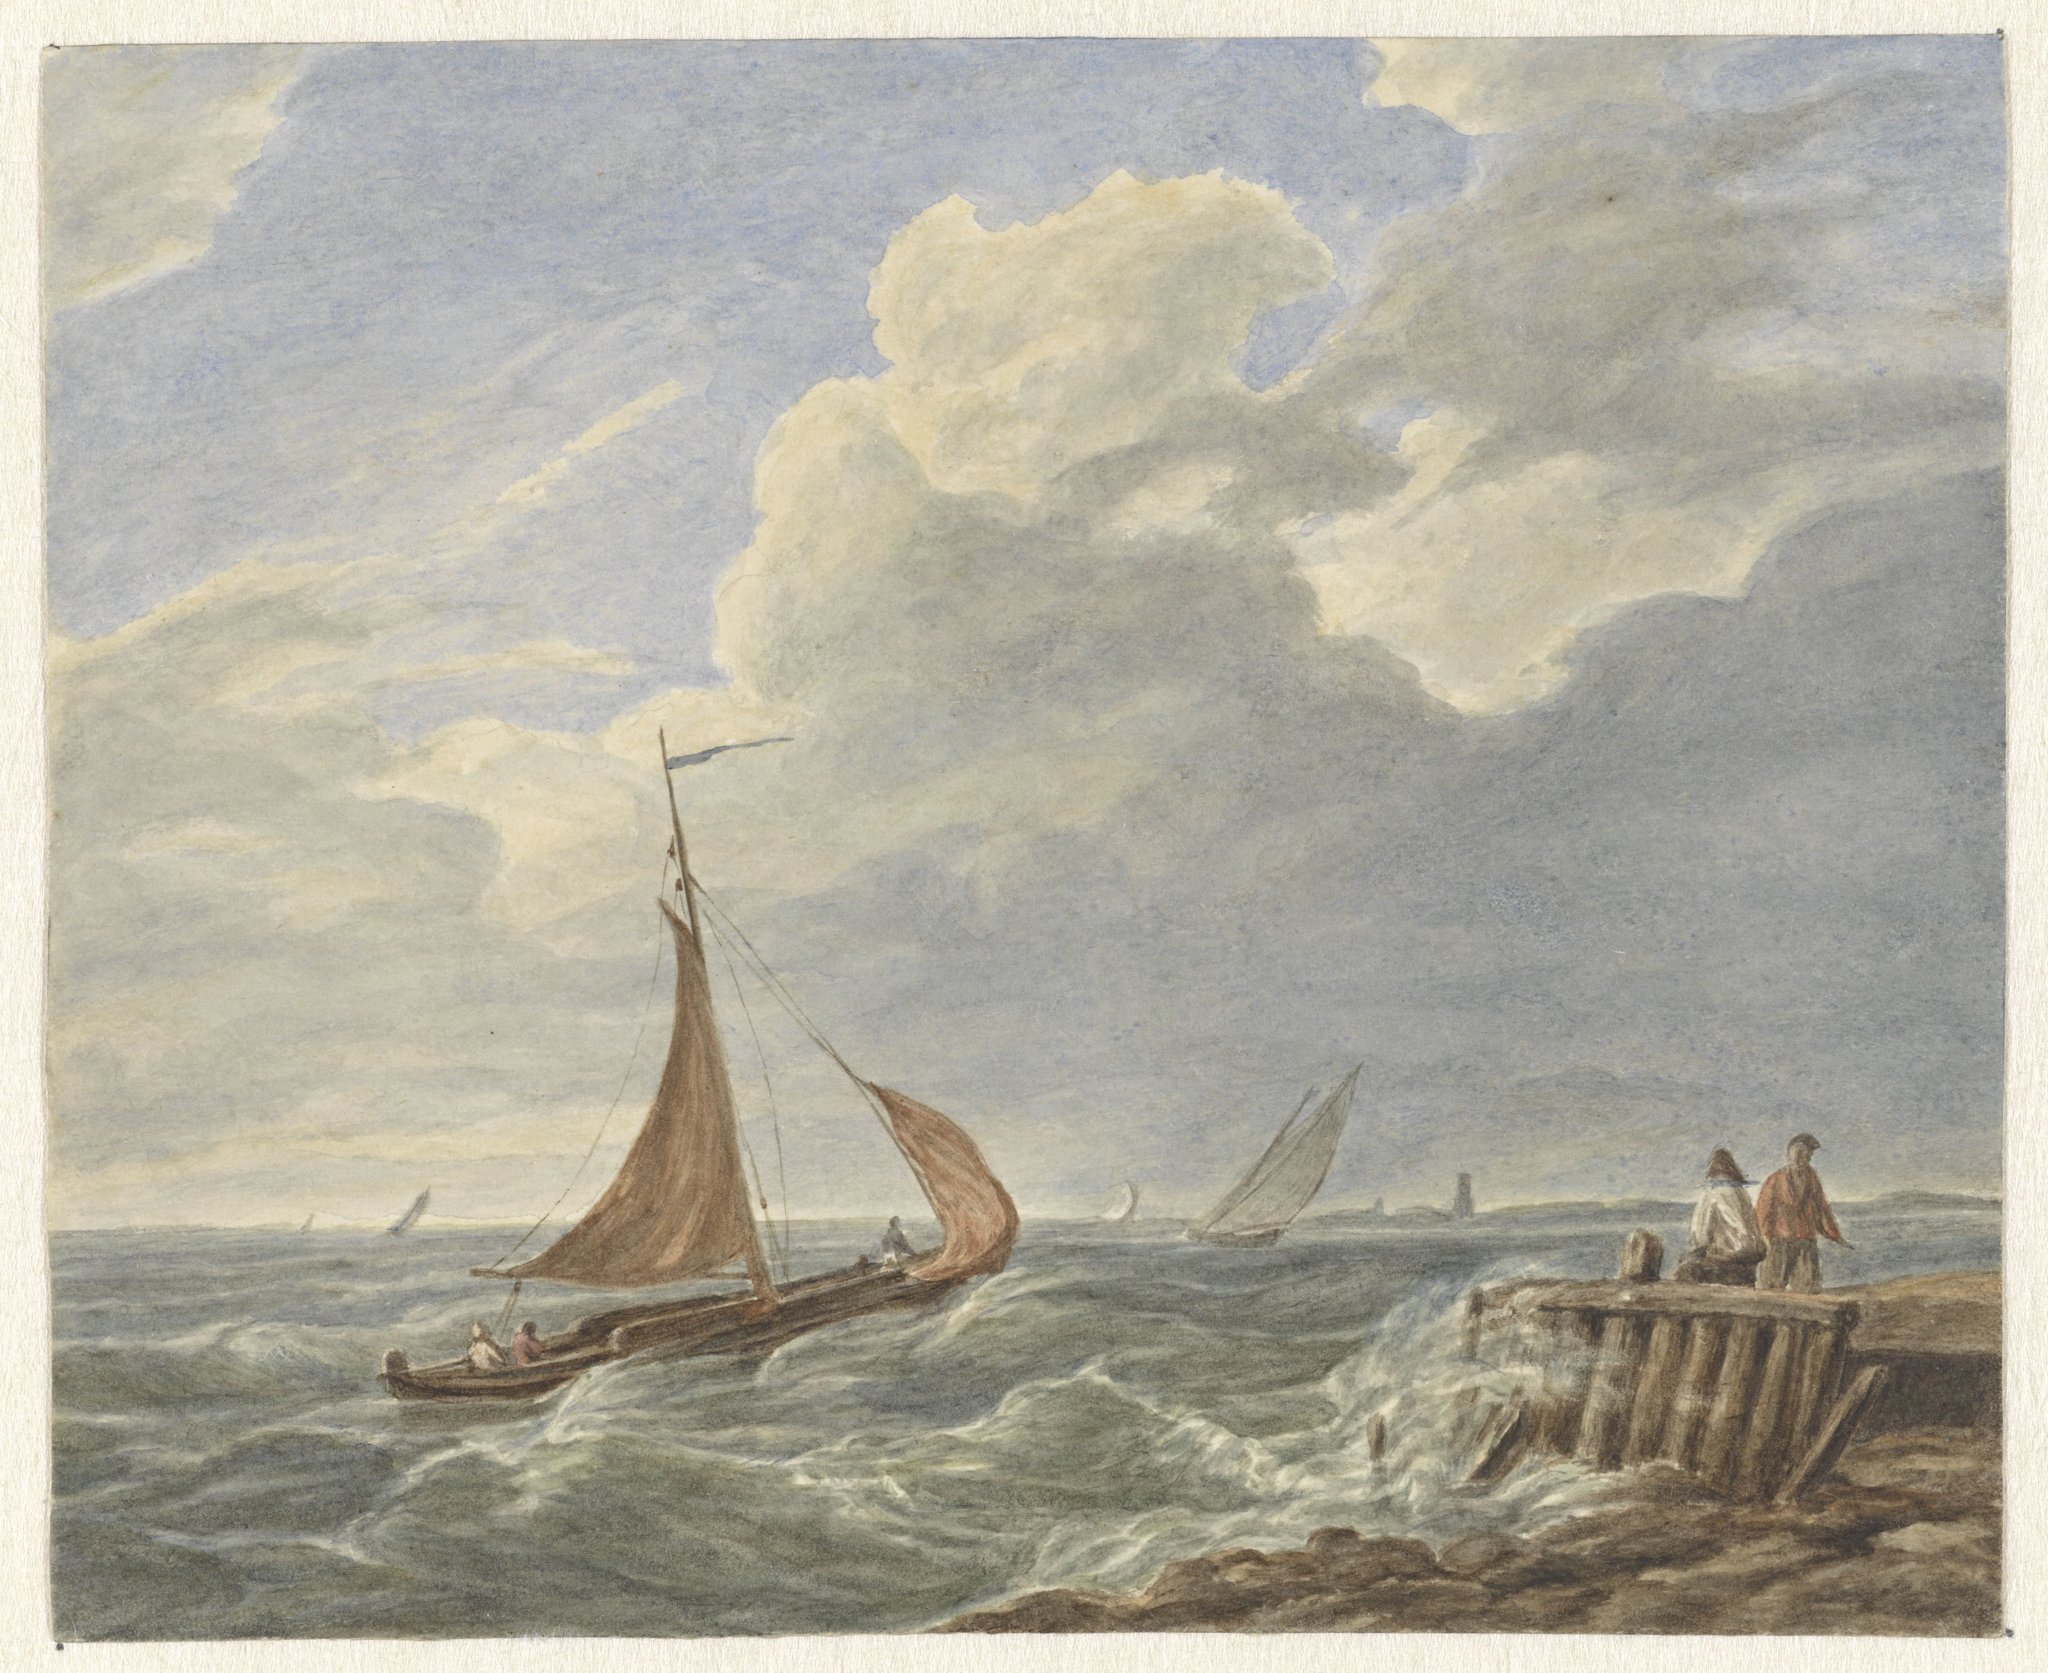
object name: watercolor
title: Woelig water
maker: matthijs maris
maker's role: draughtsman, painter, print maker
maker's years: 1839-1917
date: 1849-1917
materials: paper, watercolor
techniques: brush